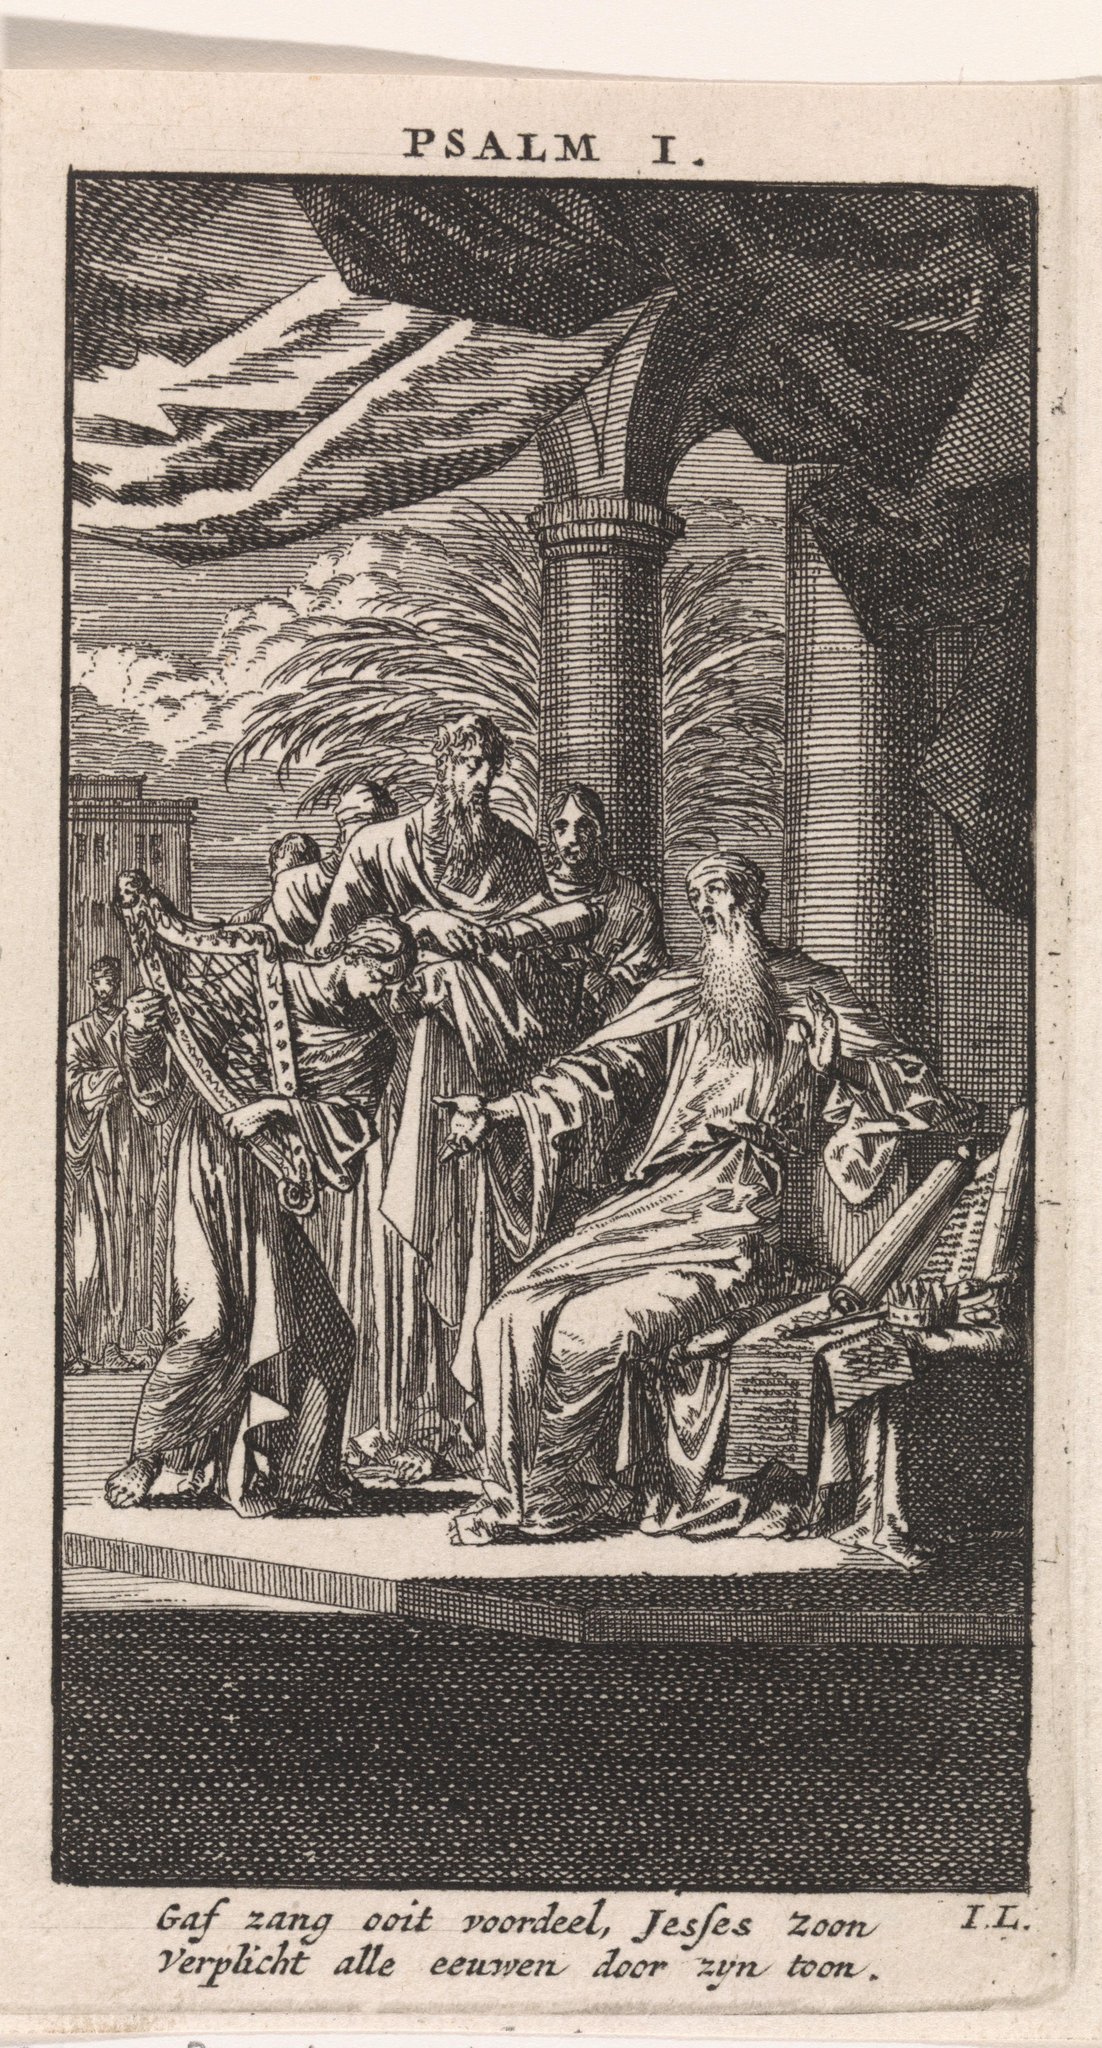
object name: book illustration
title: Koning David ontvangt zijn harp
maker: jan luyken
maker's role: draughtsman, print maker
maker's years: 1649-1712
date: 1712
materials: paper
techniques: etching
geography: amsterdam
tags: david as harpist at saul's court (1 samuel 16:14-23)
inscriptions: collector's mark: Lugt 2228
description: Illustratie voor: Luyken, Jan. Bybel printen. Amsterdam: Pieter Arentsz. II (wed.) en Cornelis van der Sys, 1712, p. 14.